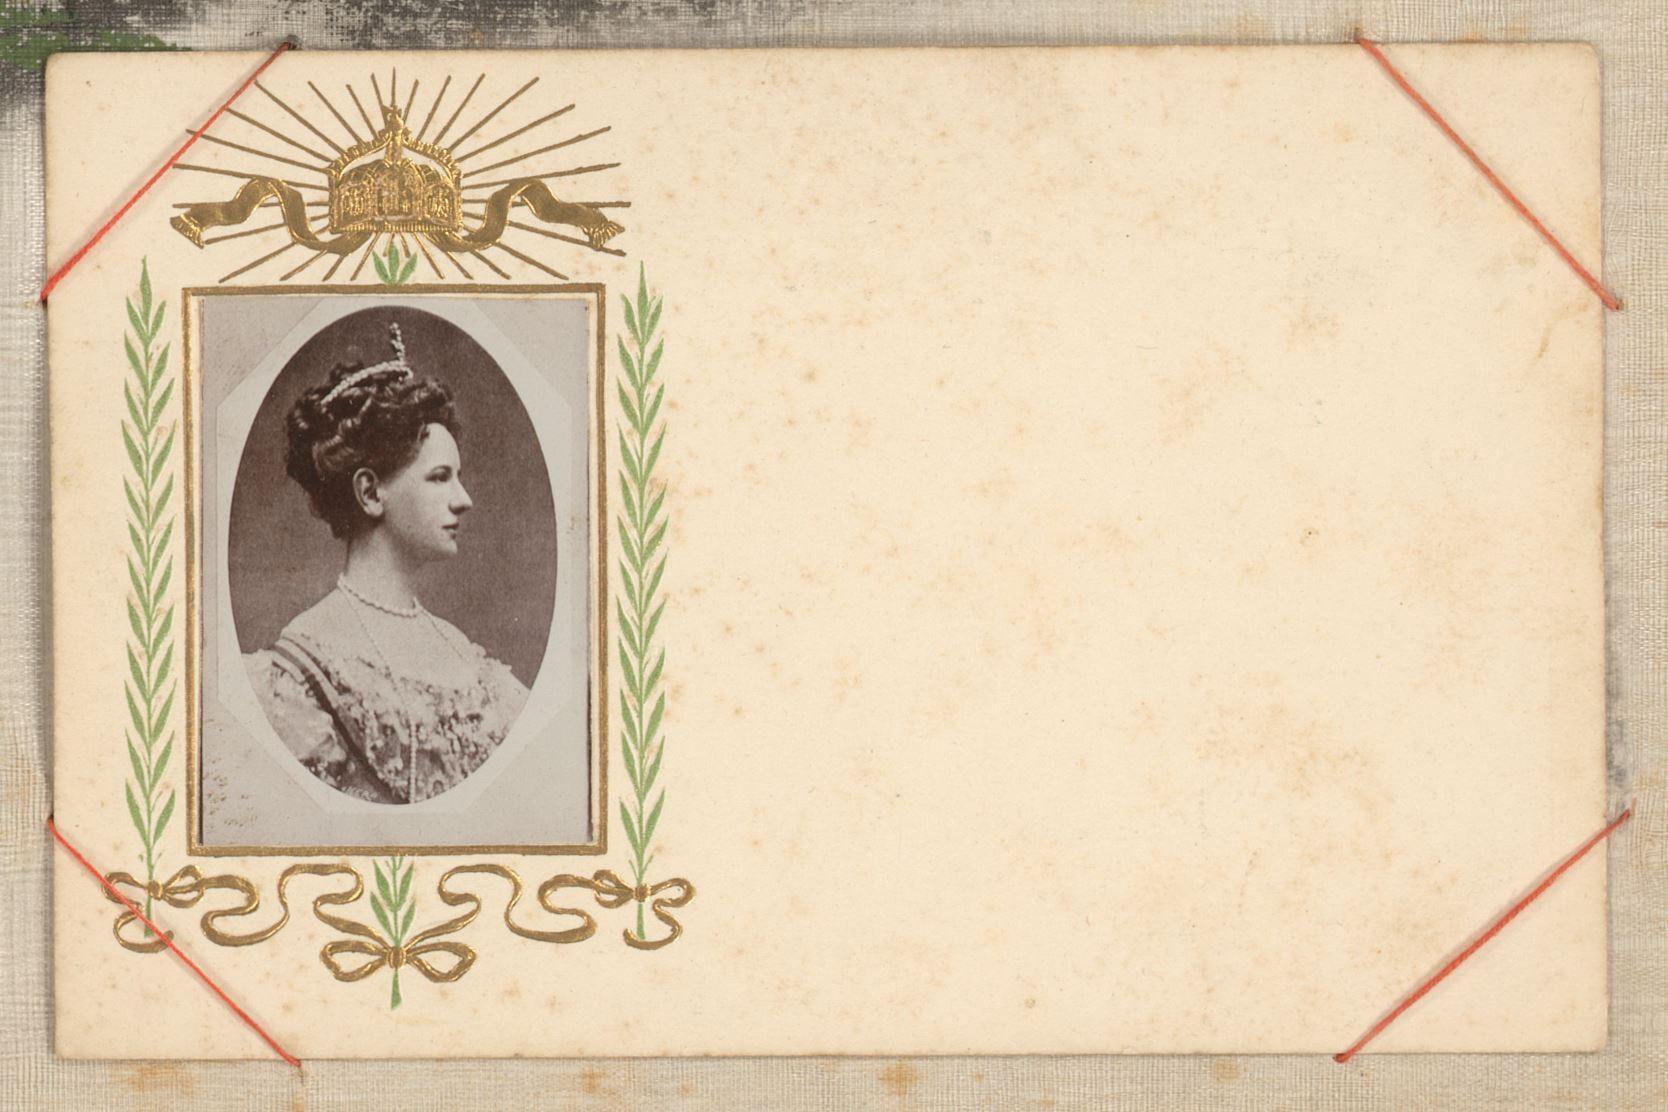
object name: photomechanical print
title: Portret van koningin Wilhelmina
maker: Anonymous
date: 1900-1910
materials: cardboard, paint, paper, silk, textile, watercolor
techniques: blind stamped, brush, photograph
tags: print maker, wilhelmina of the netherlands, historical persons, king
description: Deze prent maakt deel uit van een album.